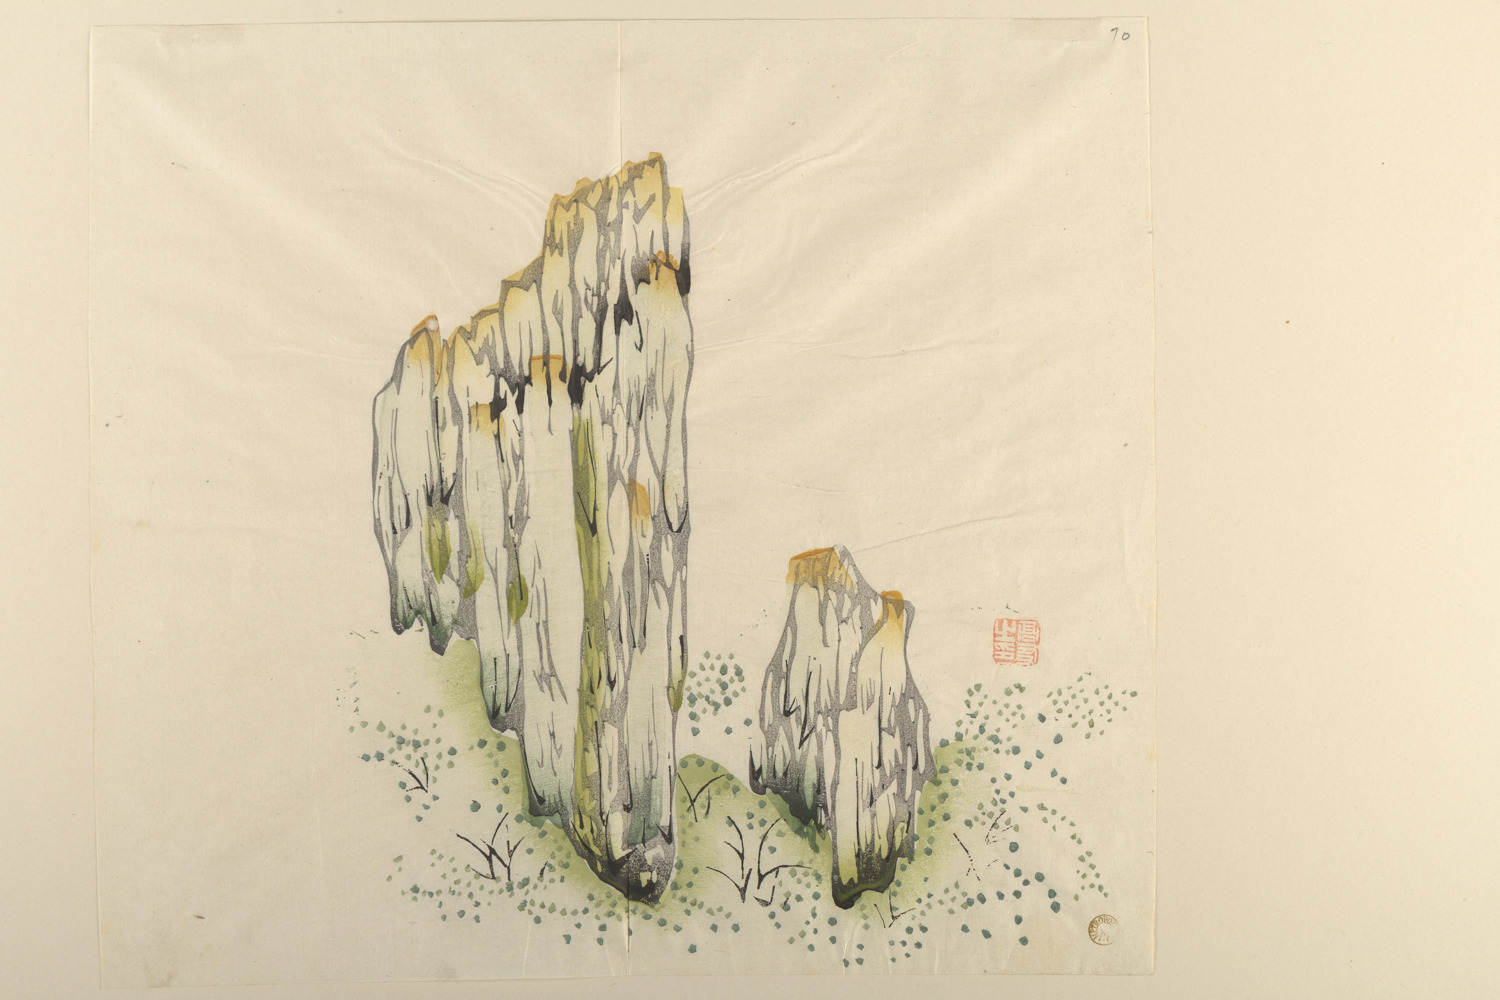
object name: print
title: Page from Shi Zhu Zhai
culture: chinese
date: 1736-1795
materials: ink, paper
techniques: polychrome, woodblock print